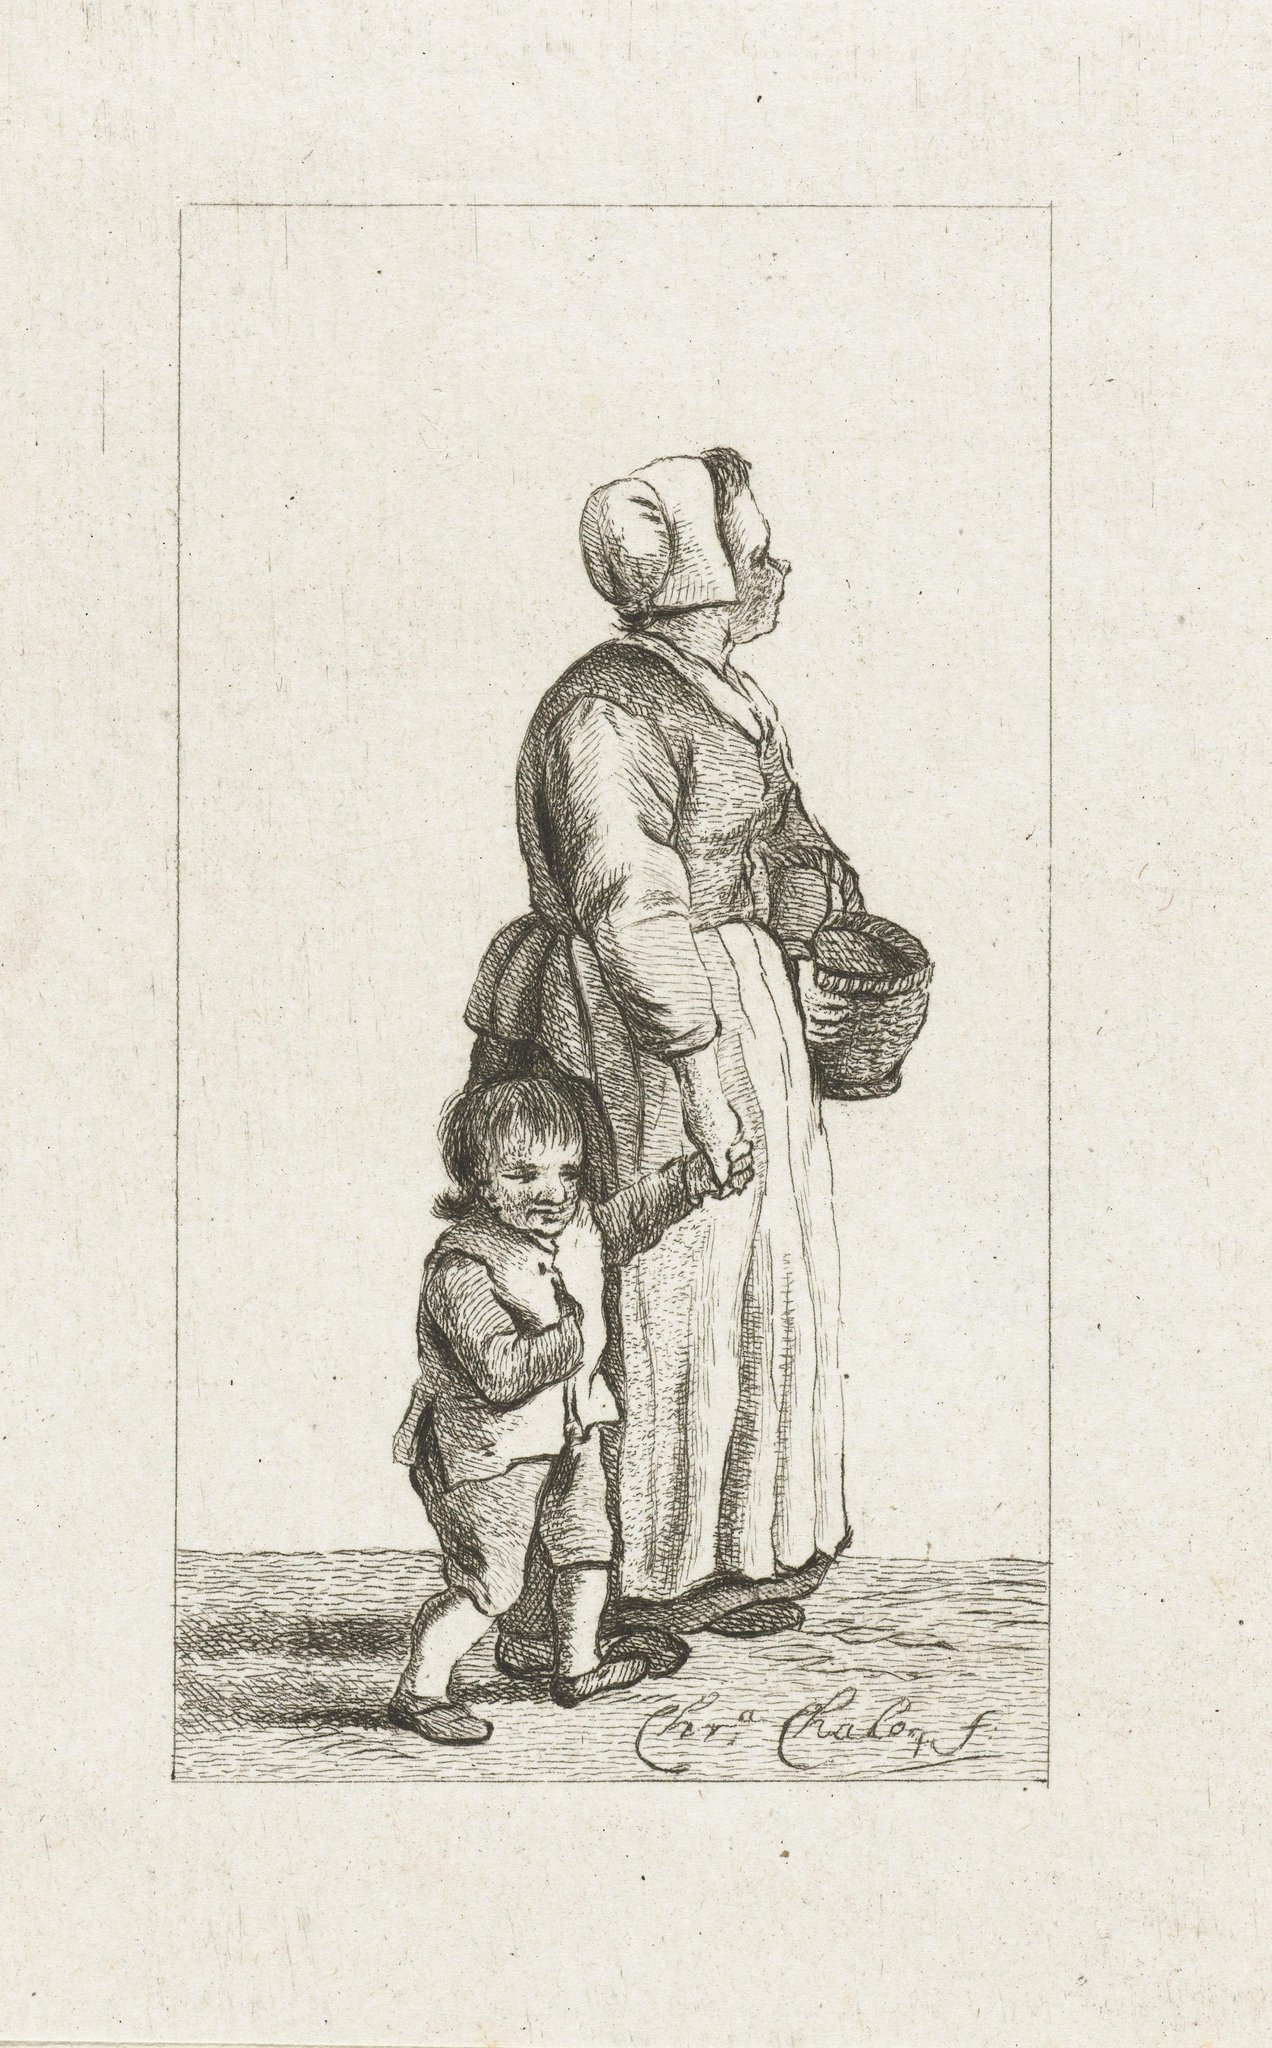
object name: print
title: Staande vrouw met kind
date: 1779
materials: paper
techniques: etching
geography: leiden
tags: carrying something in basket, bag, rucksack, etc., mother and child(ren), woman and child(ren) (family group) (with number of children)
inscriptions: collector's mark: Lugt 2233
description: Een moeder met haar zoontje. Lopend naar rechts. De moeder draagt een mandje in de andere hand.